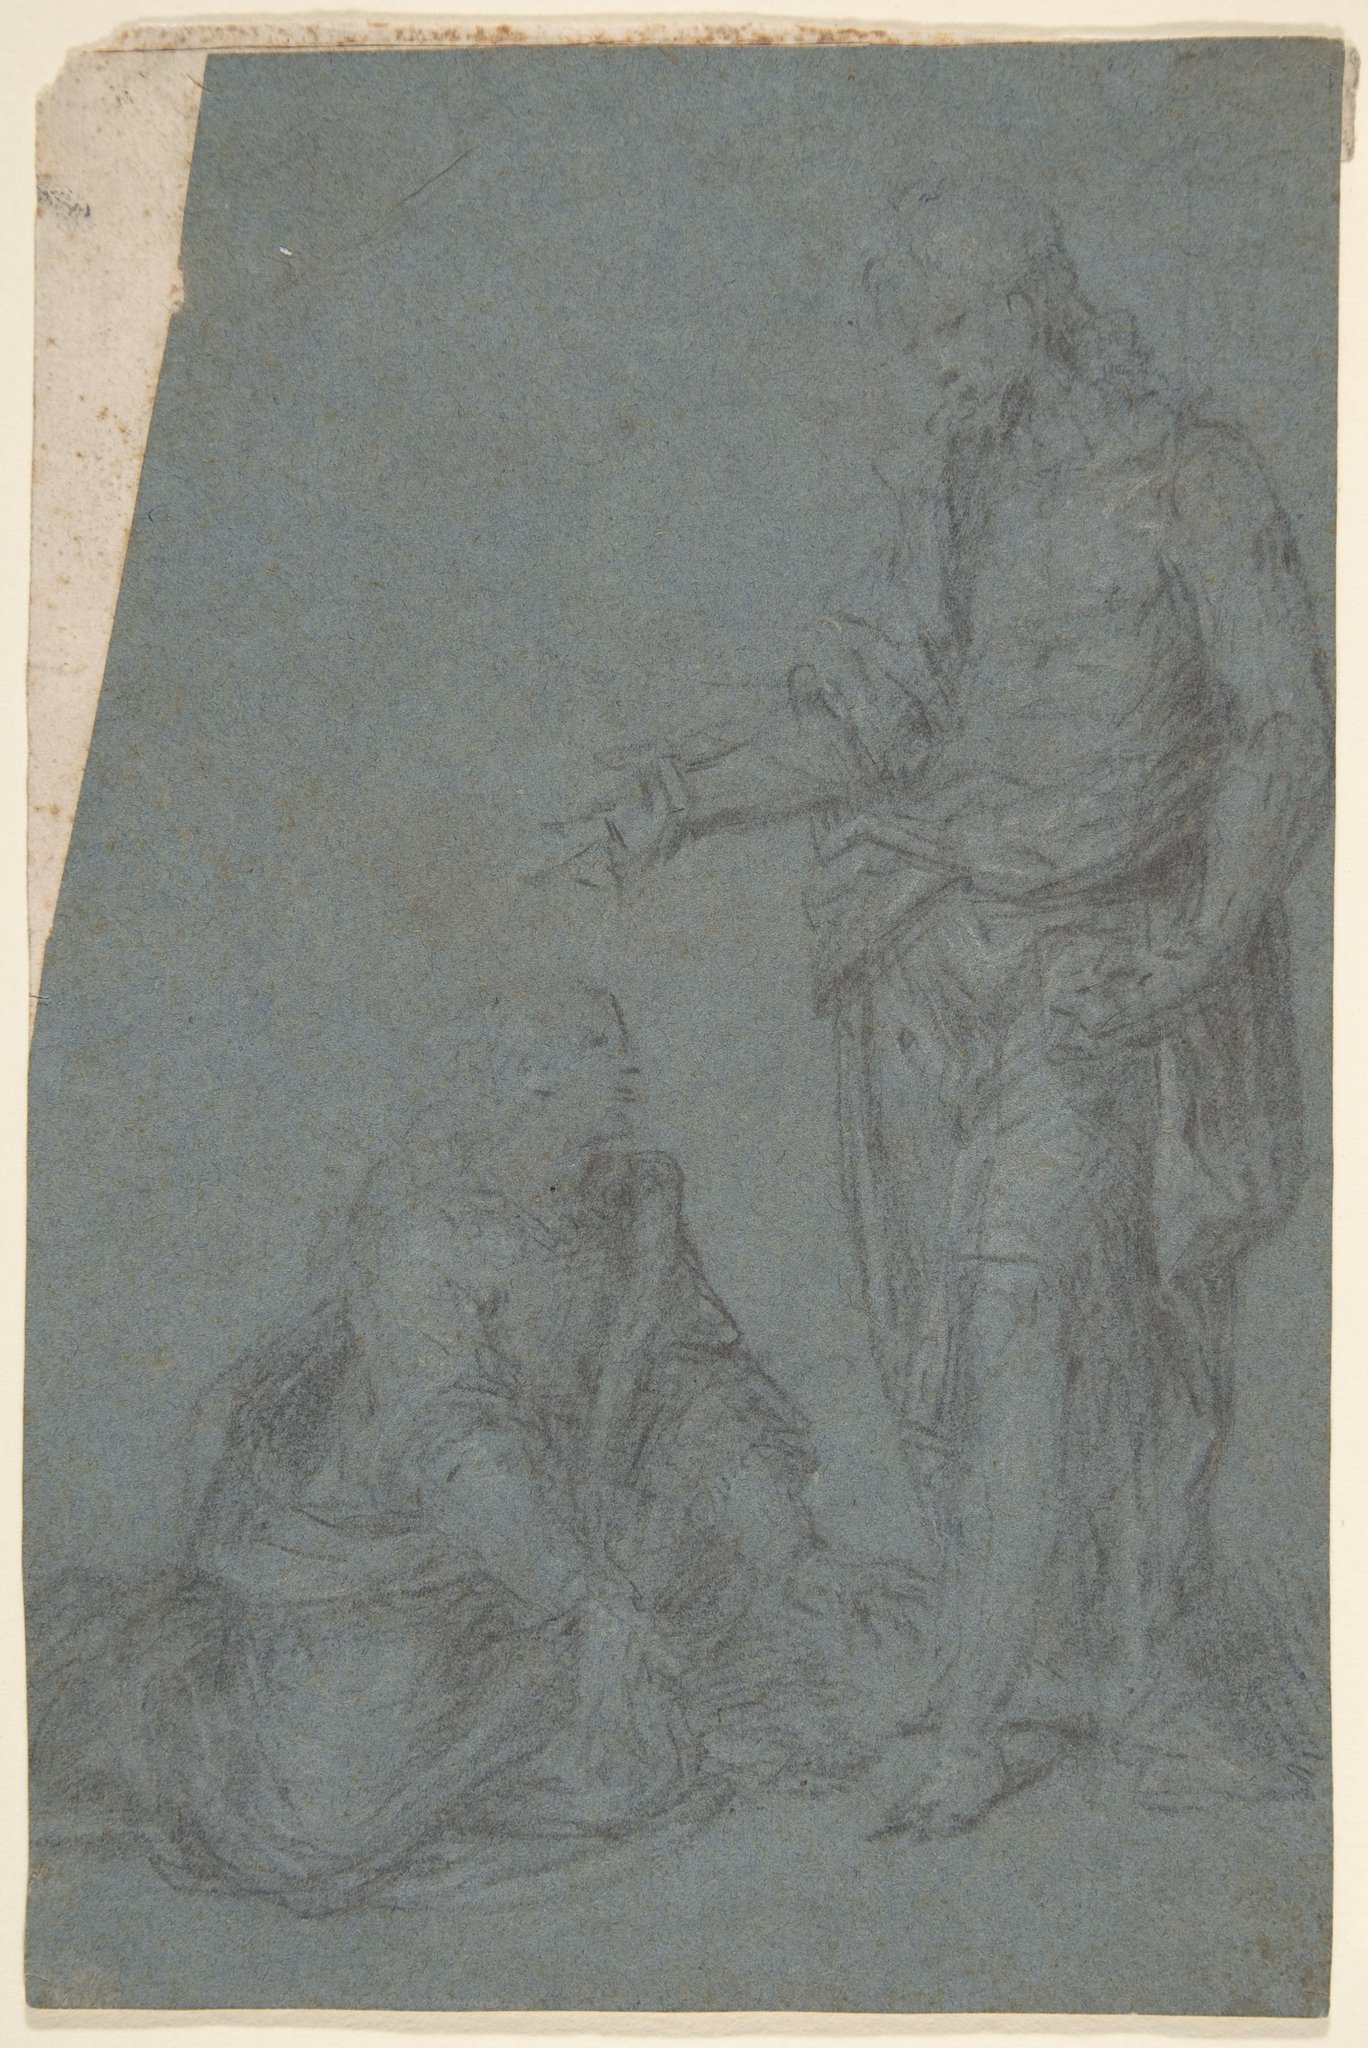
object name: drawing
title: Noli me tangere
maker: anonymous, italian, florentine, 16th century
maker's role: artist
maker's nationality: italian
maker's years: 1500-1600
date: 1580-1610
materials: chalk, paper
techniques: highlighting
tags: mary magdalene,jesus